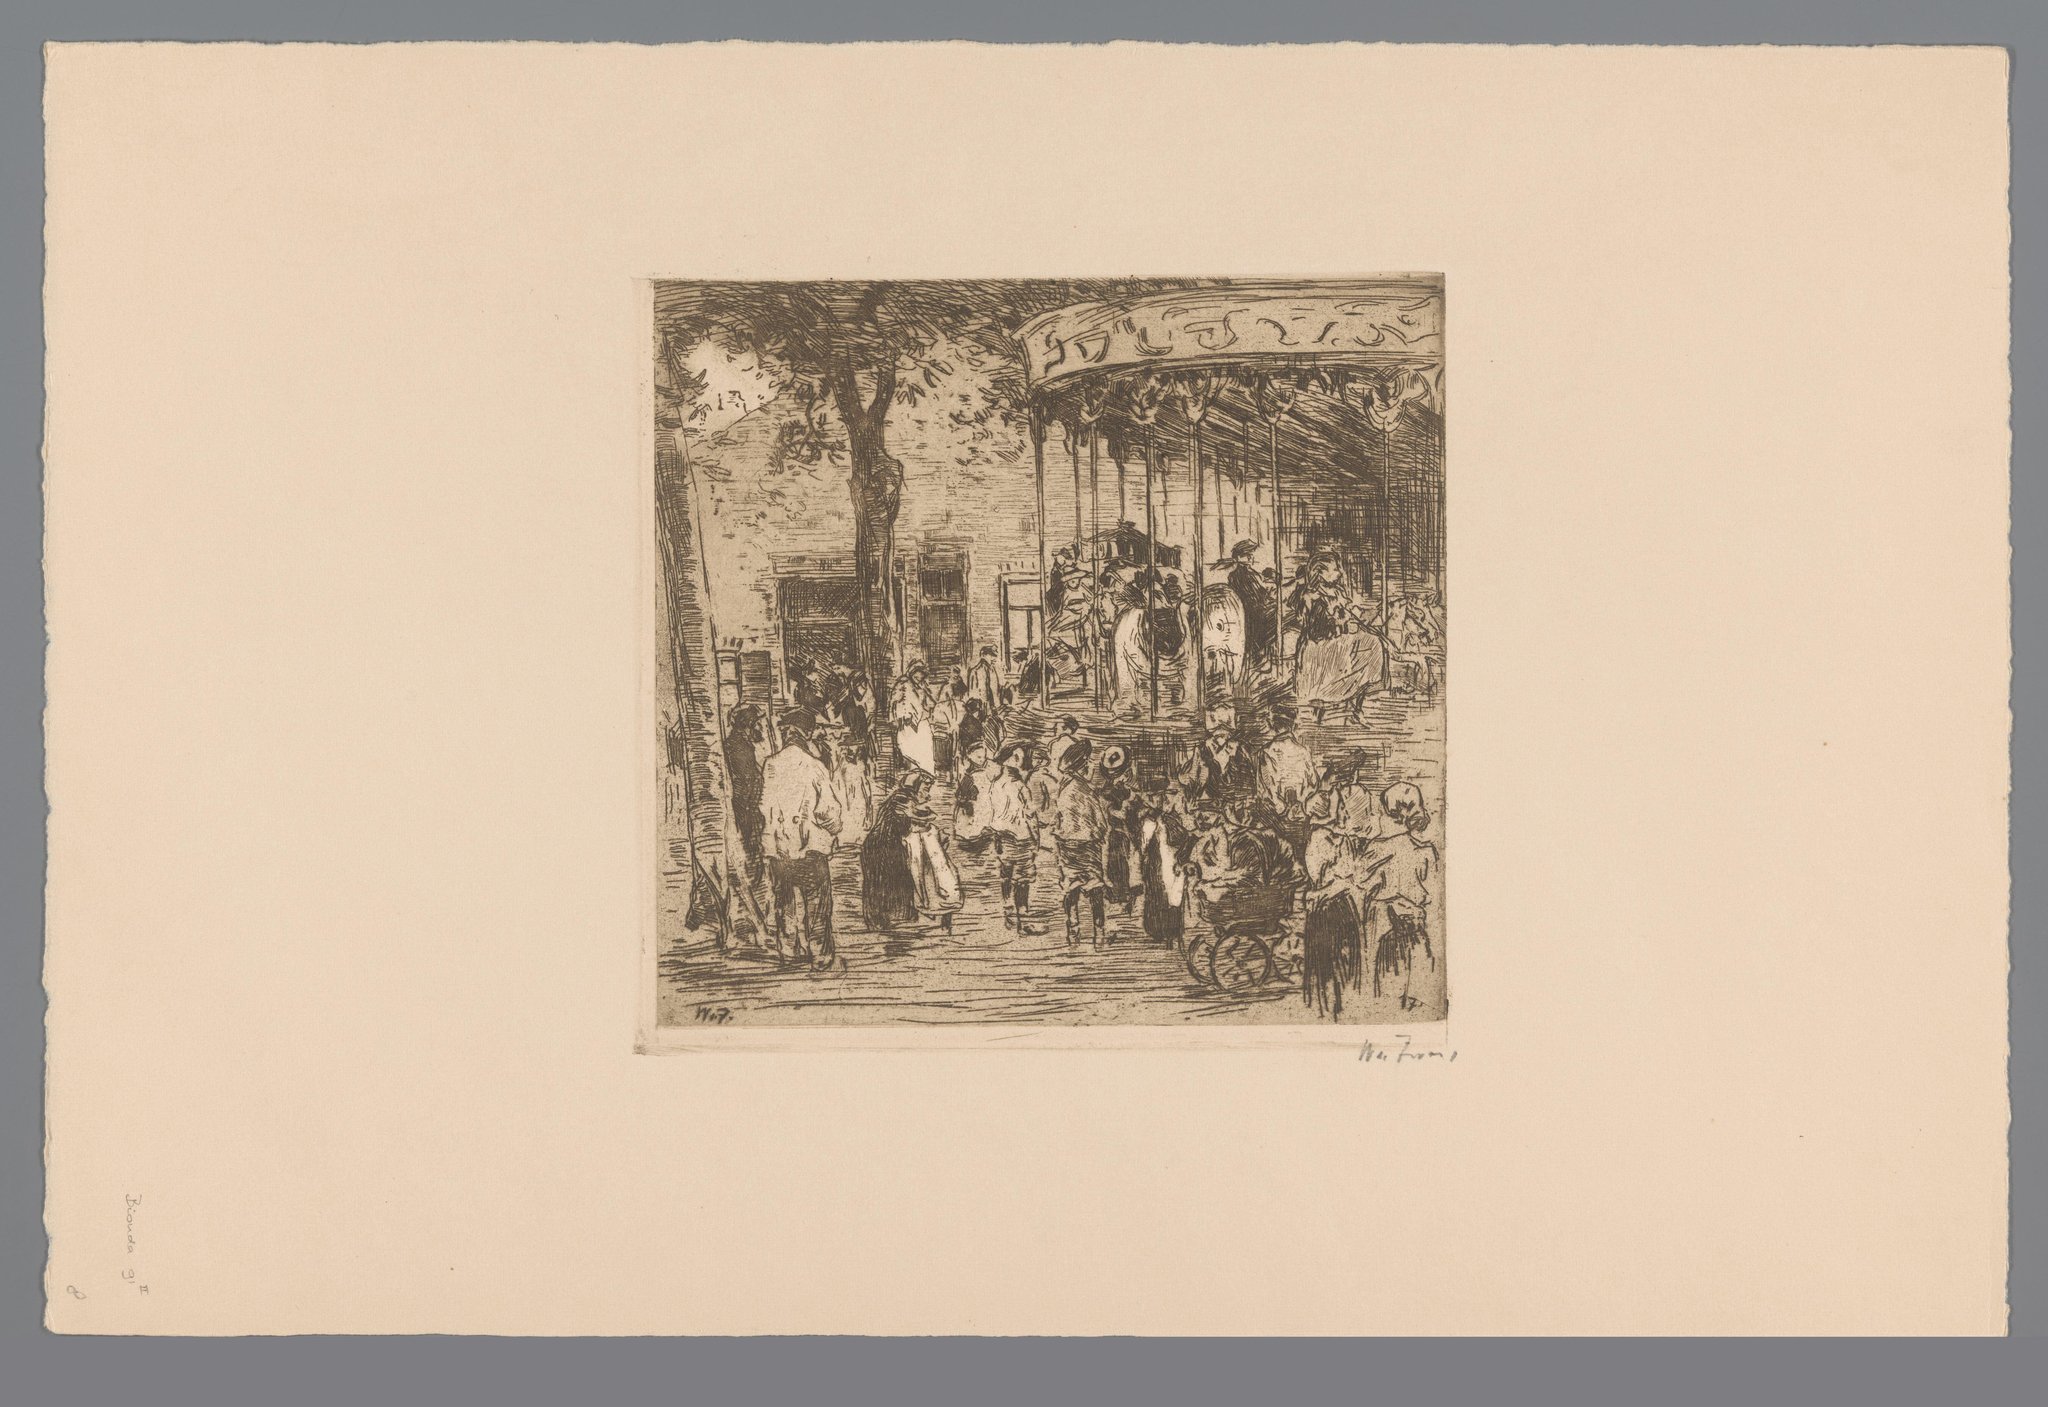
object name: print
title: Draaimolen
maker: willem de zwart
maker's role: draughtsman, painter, print maker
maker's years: 1862-1931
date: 1924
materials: paper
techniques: drypoint, etching, intaglio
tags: merry-go-round, roundabout; chair o'plane, pleasure fair and circus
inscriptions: collector's mark: Lugt 2228, collector's mark: Lugt 2760